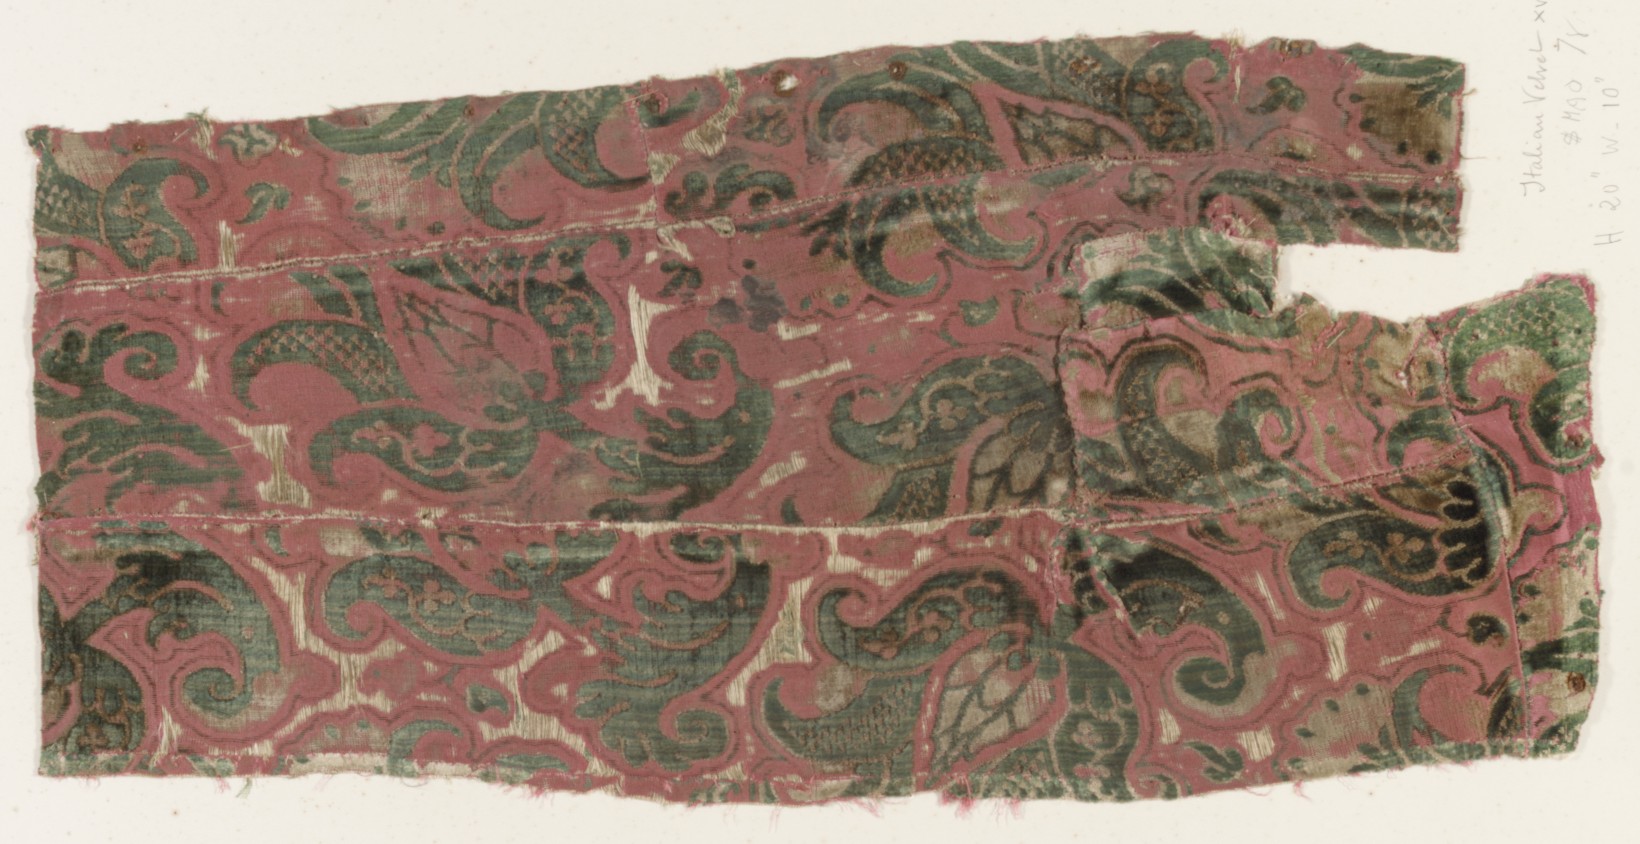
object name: fragment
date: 1601-1700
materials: silk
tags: flowers